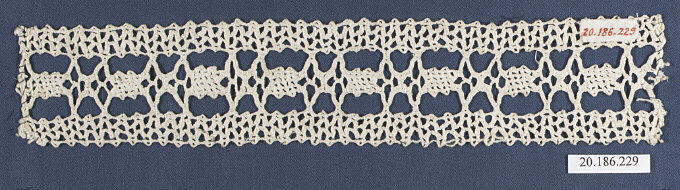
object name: insertion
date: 1501-1600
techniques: lace